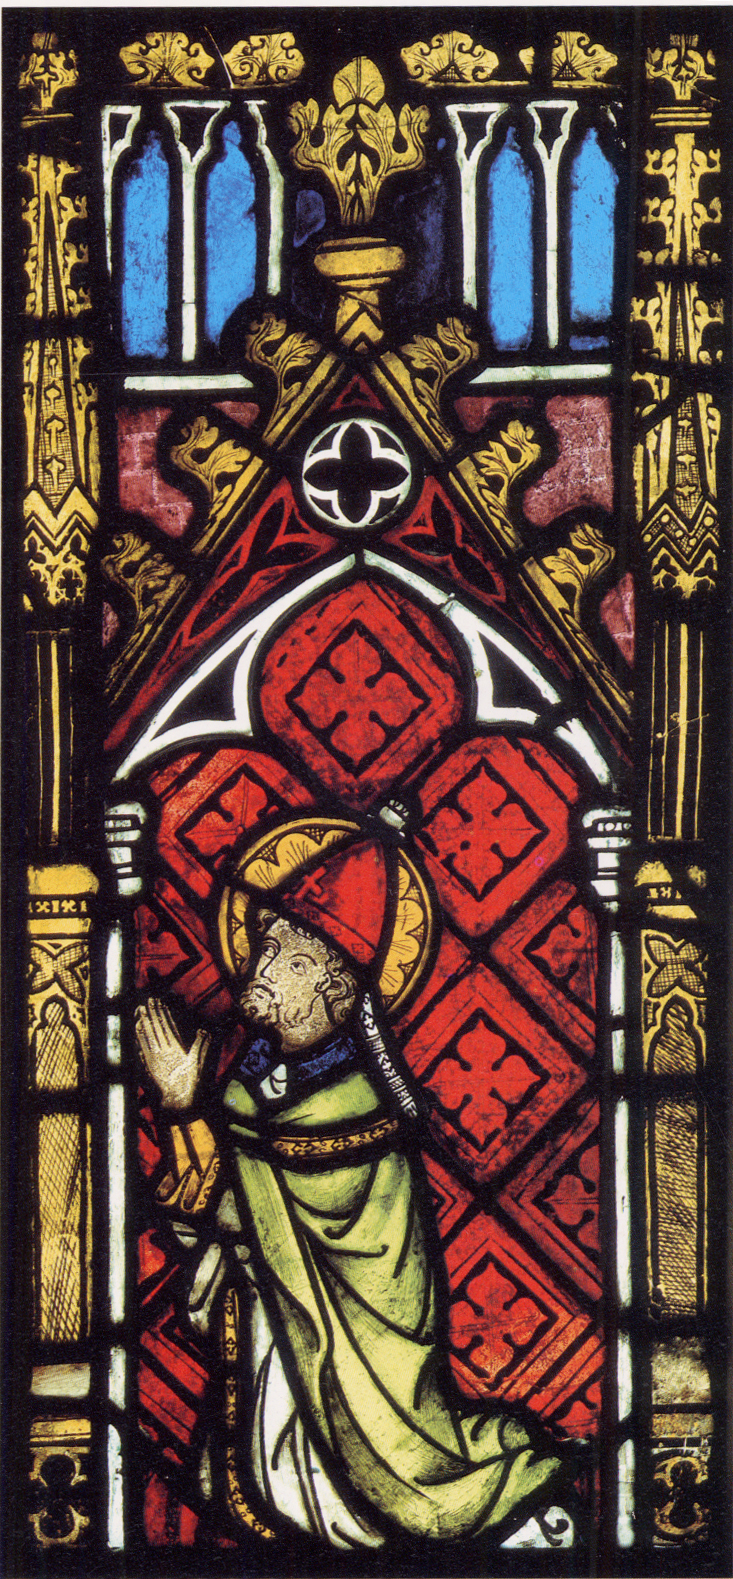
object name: panel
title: Christ Presenting the Keys to Saint Peter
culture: german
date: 1315-1320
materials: glass, lead, metal, paint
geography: germany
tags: men,saint peter